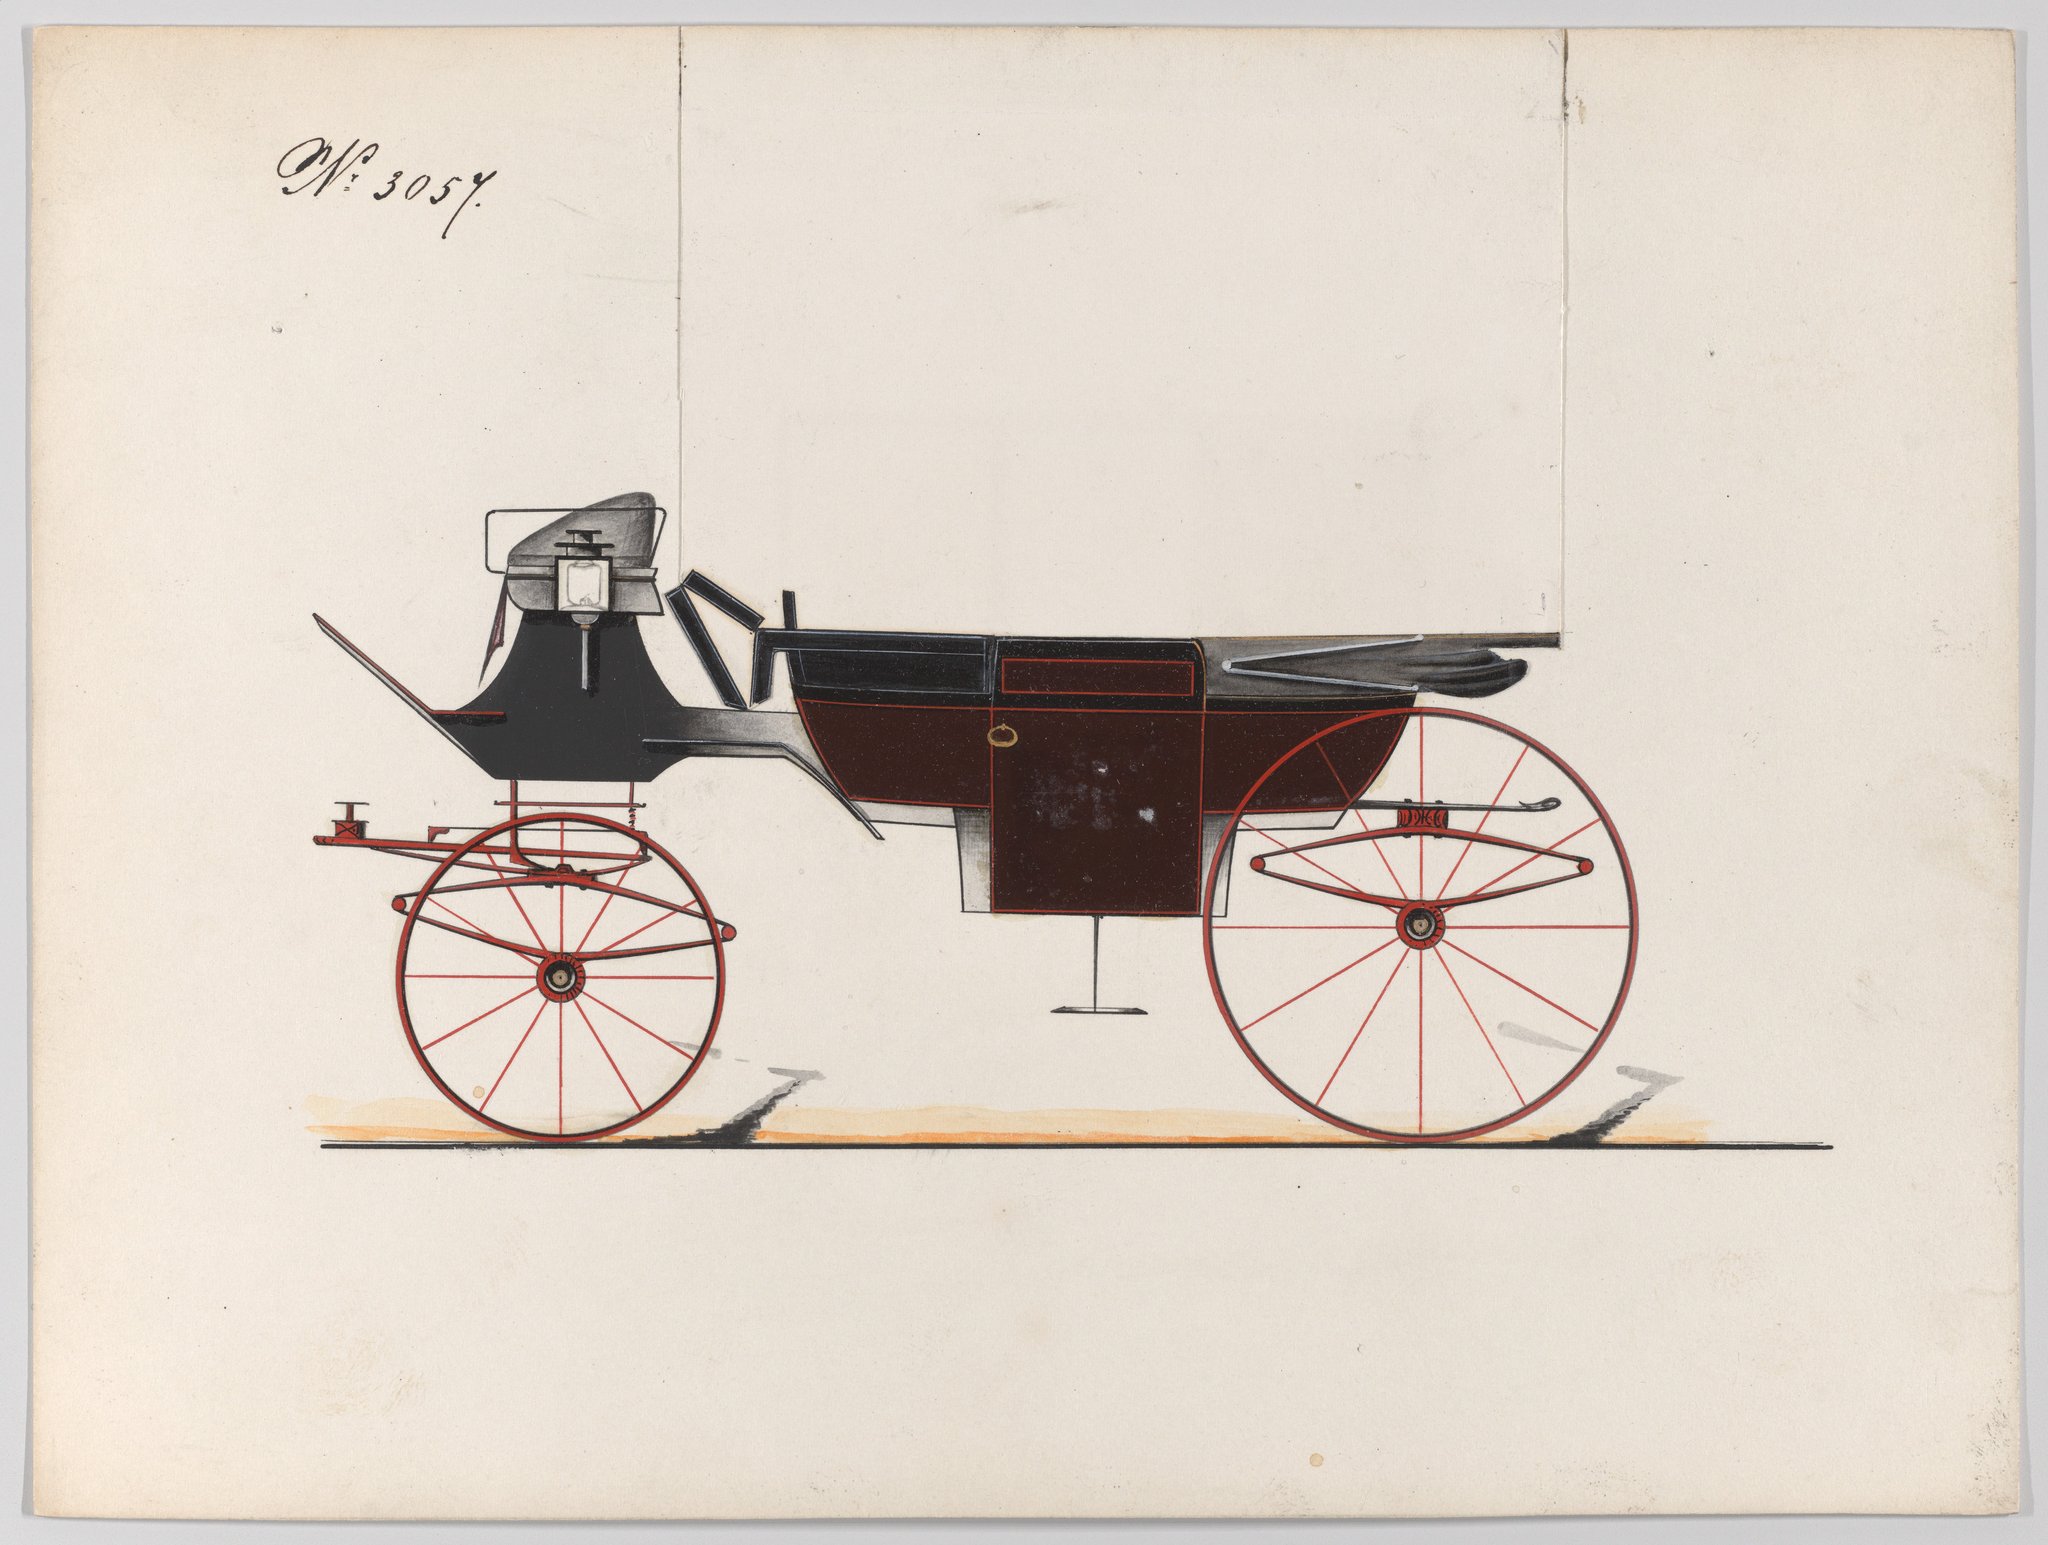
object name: drawing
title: Design for Landau, No. 3057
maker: brewster & co.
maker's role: manufacturer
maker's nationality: american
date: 1874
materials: gouache, ink, watercolor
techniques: pen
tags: carriages